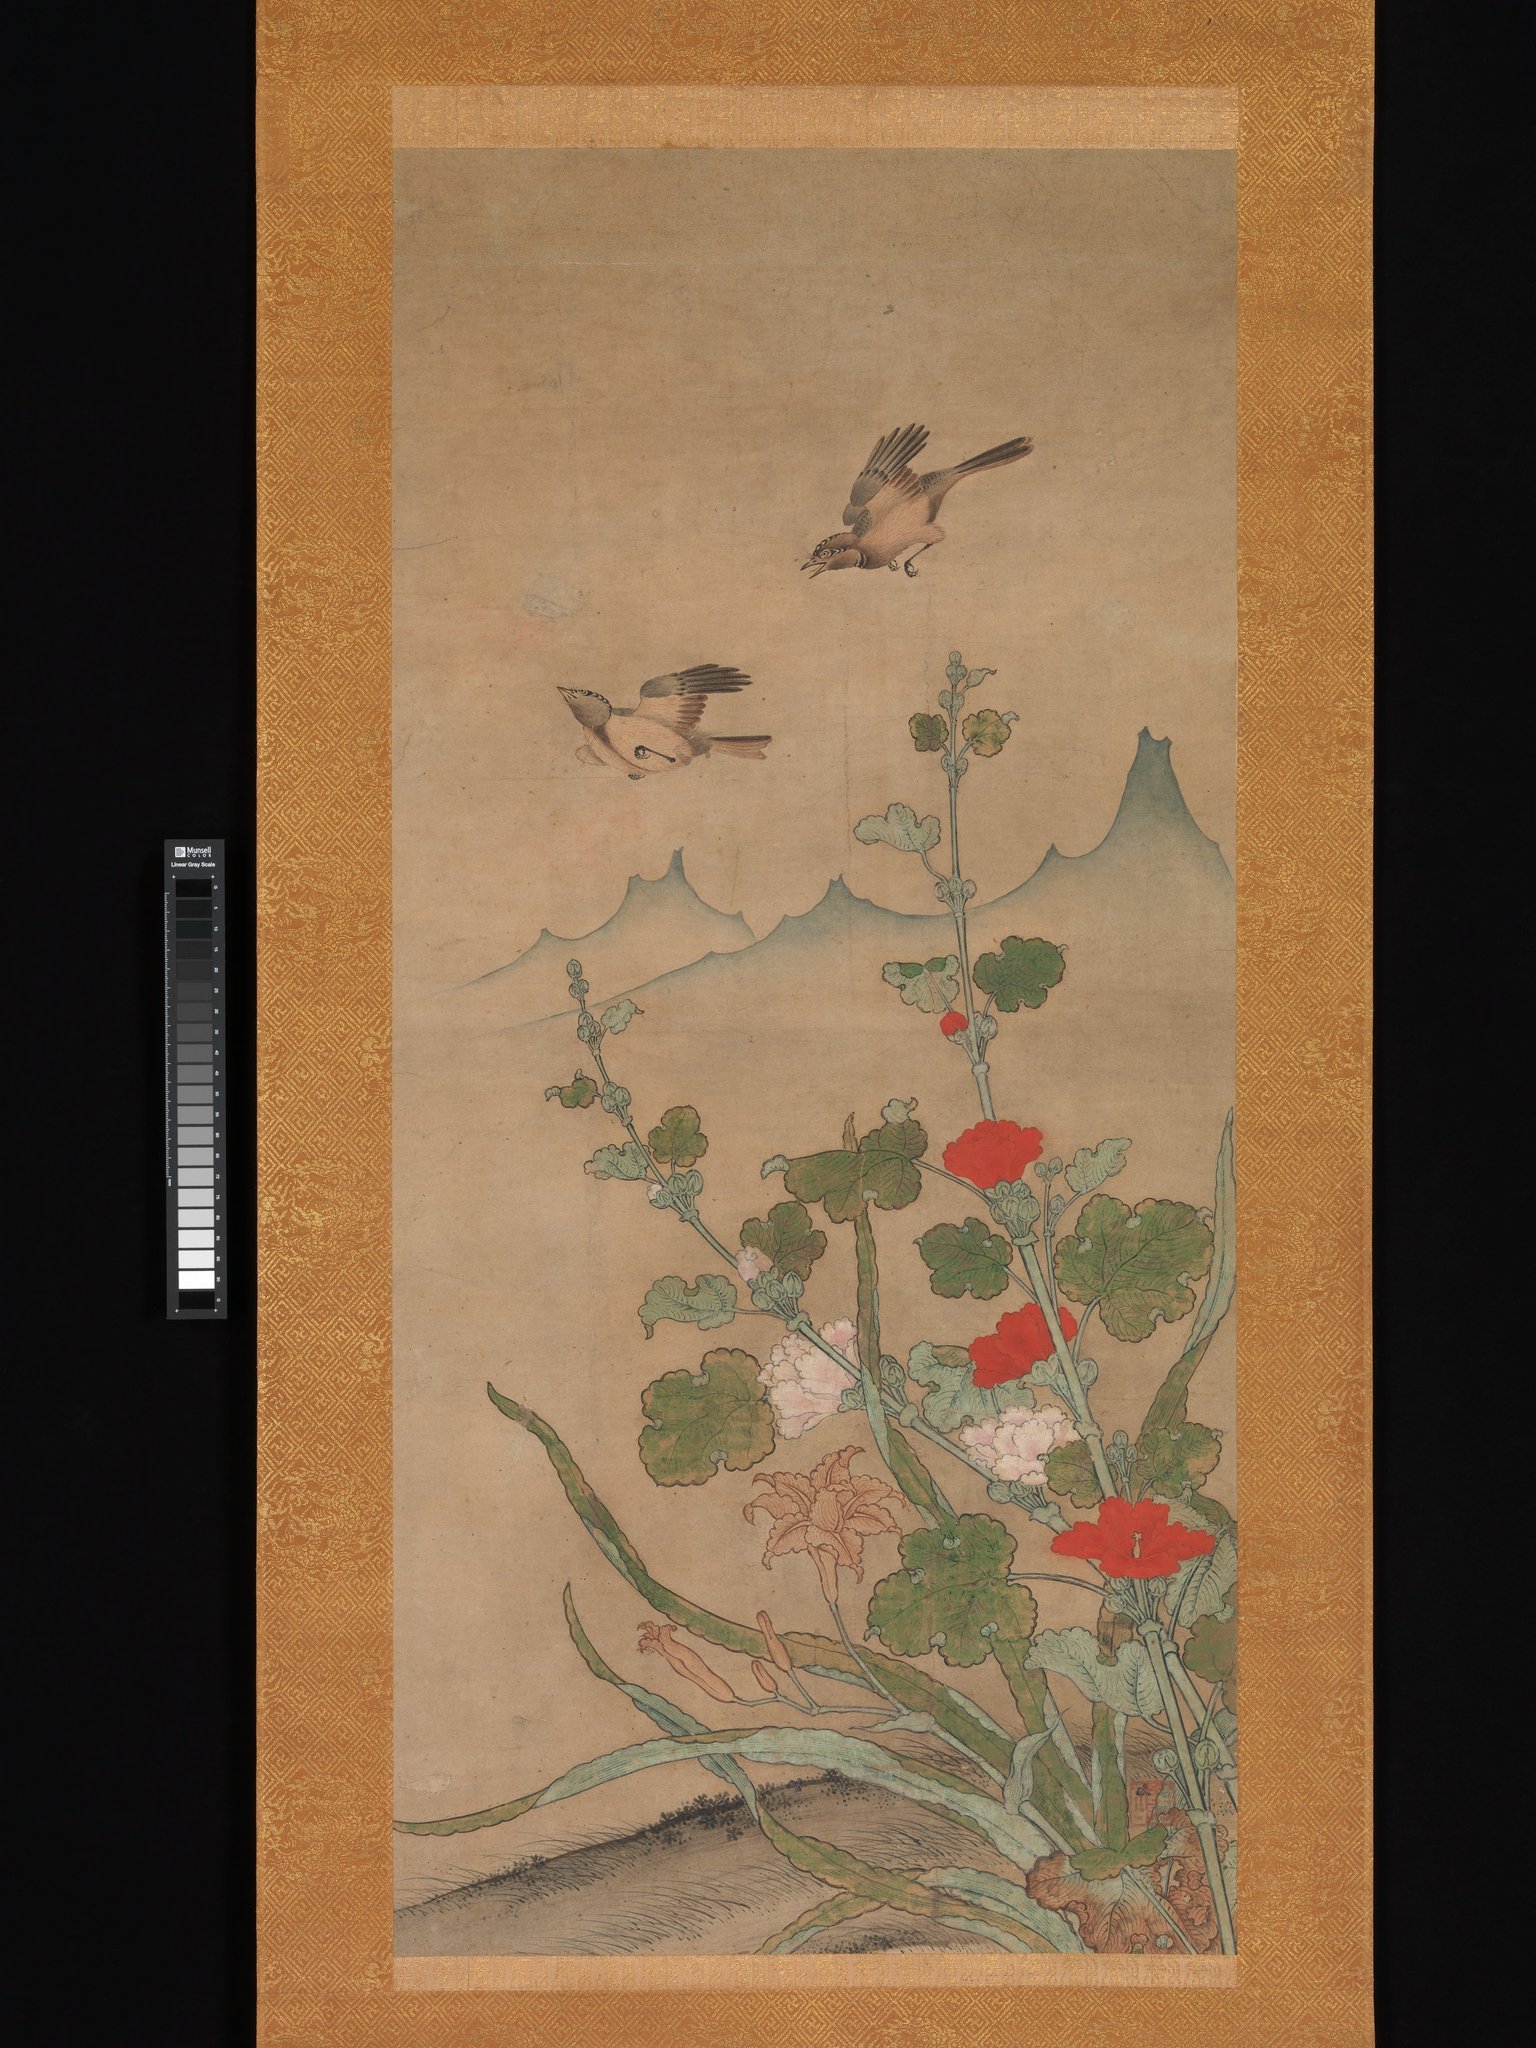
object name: hanging scroll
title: Birds and Flowers of Summer and Autumn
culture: japanese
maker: shikibu terutada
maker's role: artist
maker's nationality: japanese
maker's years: 1534-1566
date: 1534-1566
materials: ink, paper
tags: birds,flowers